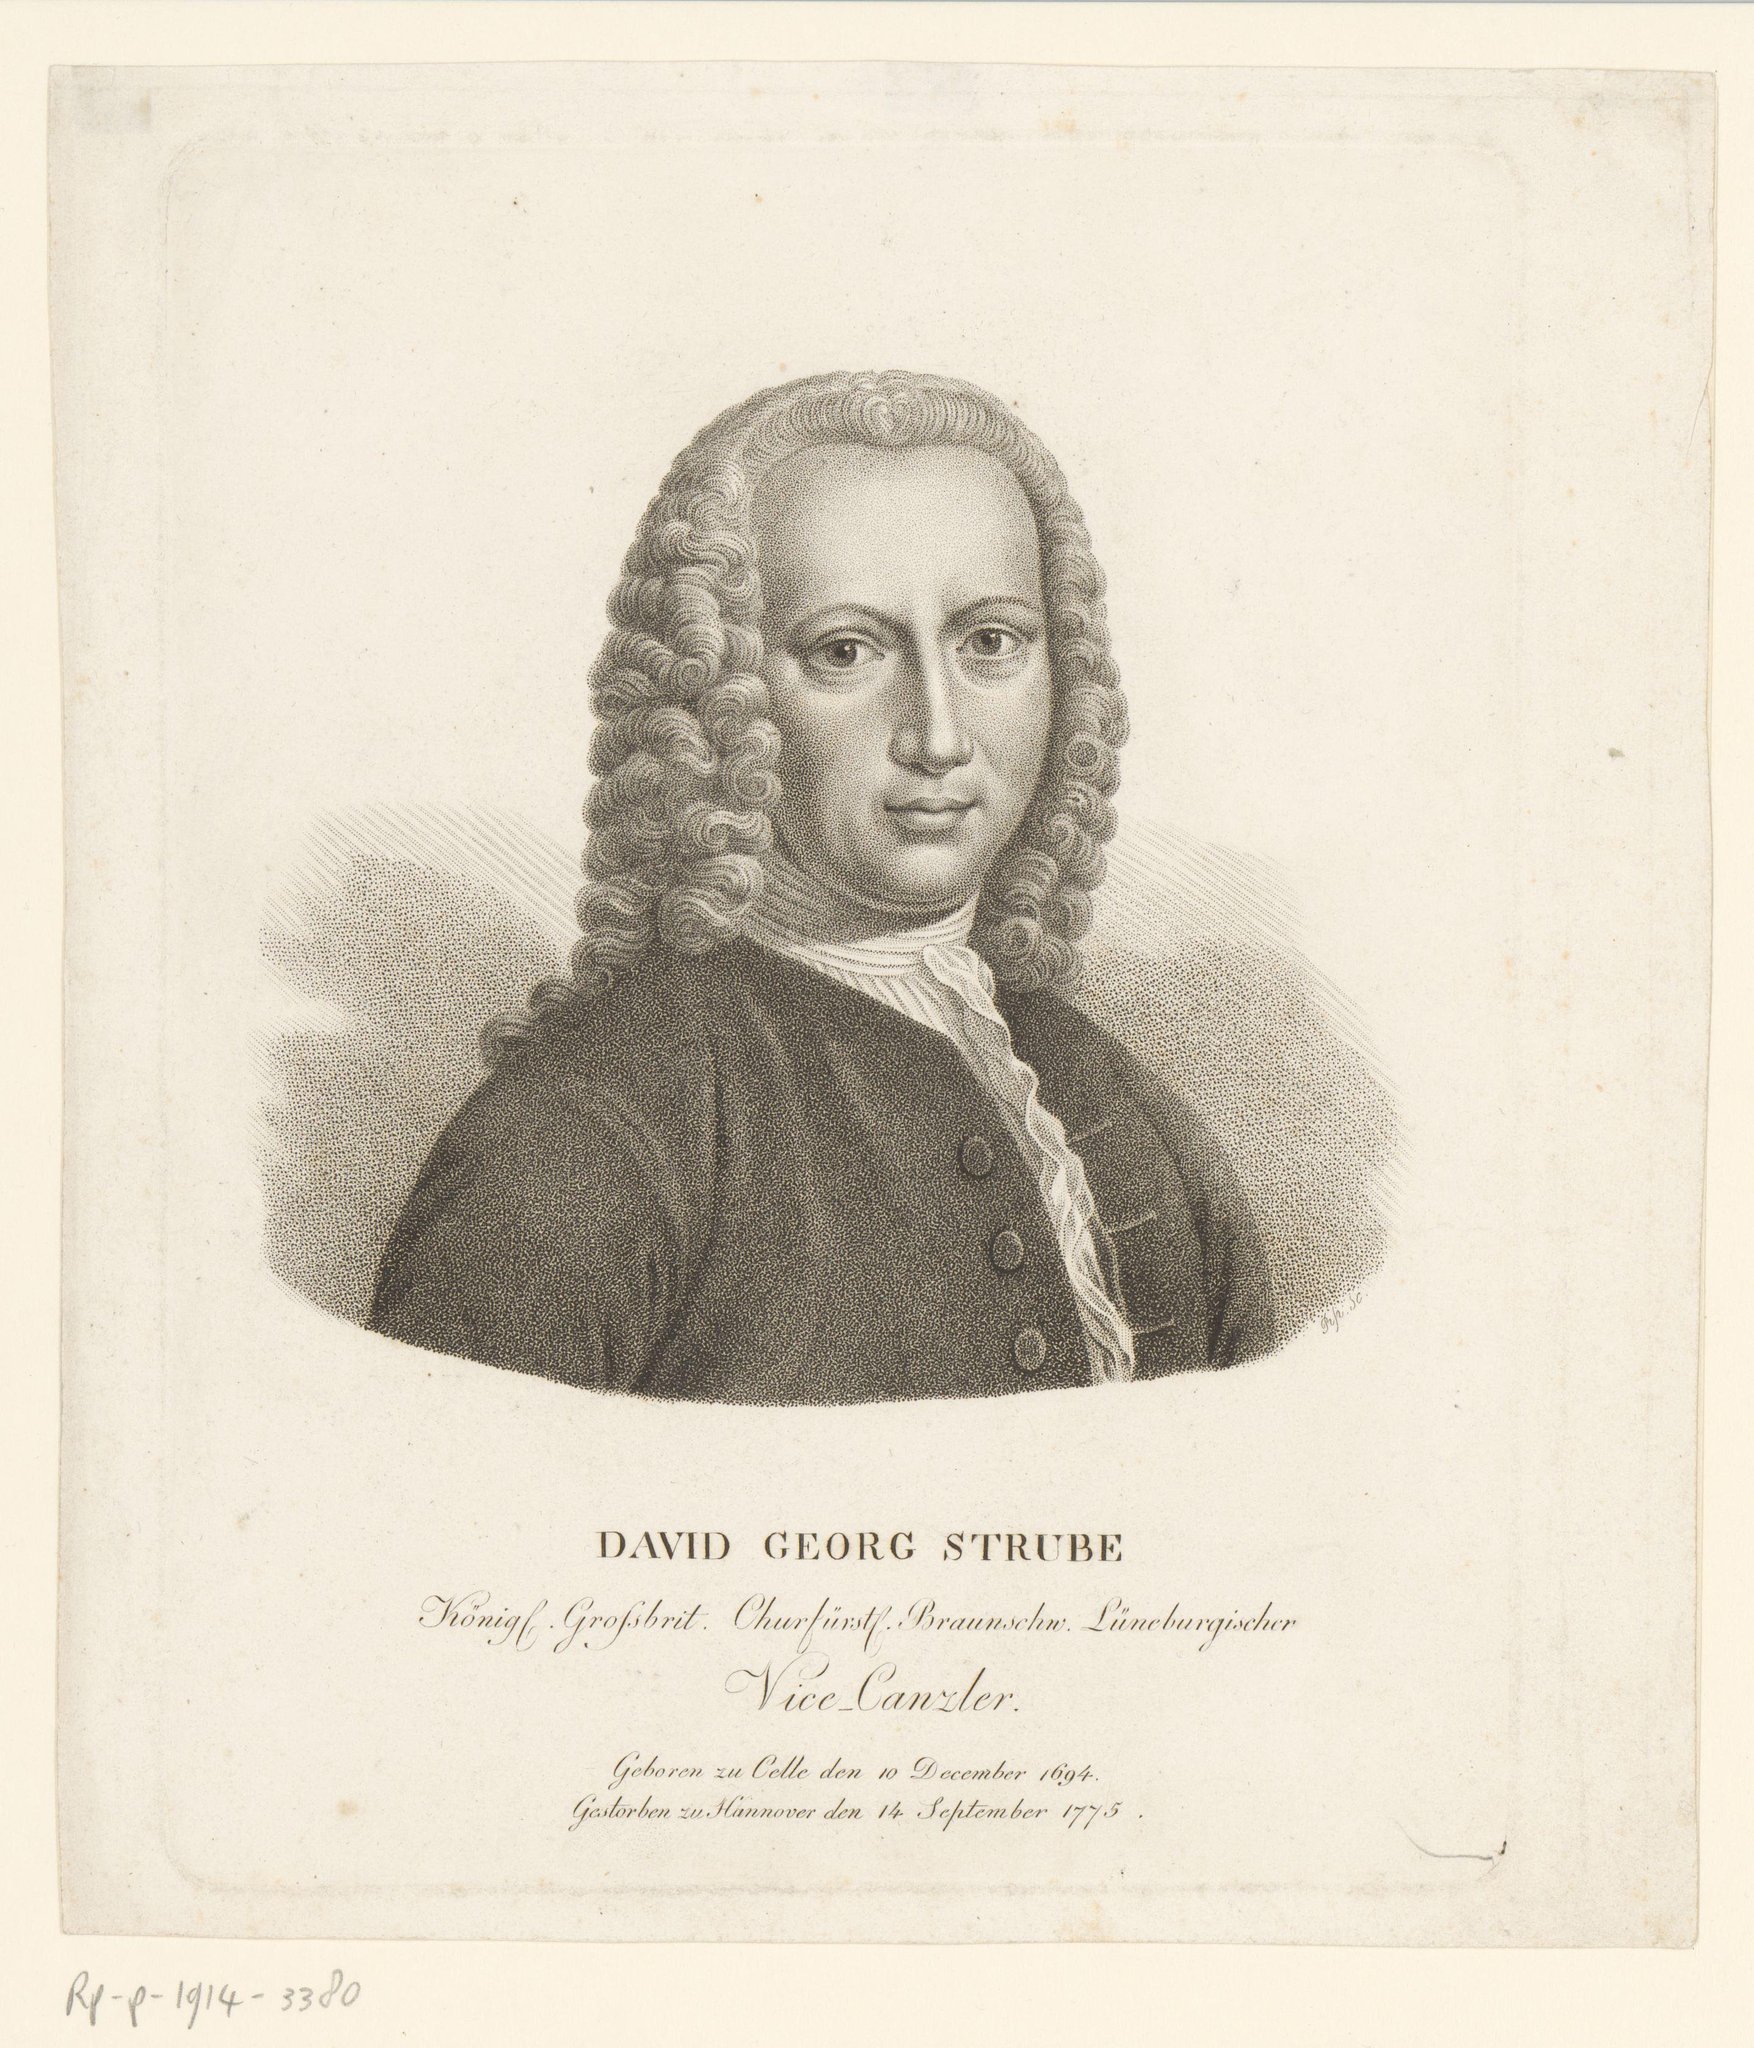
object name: print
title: Portret van David Georg Strube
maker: ernst ludwig riepenhausen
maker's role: print maker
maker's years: 1765-1840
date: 1775-1840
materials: paper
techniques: engraving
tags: historical persons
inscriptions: collector's mark: Lugt 2228